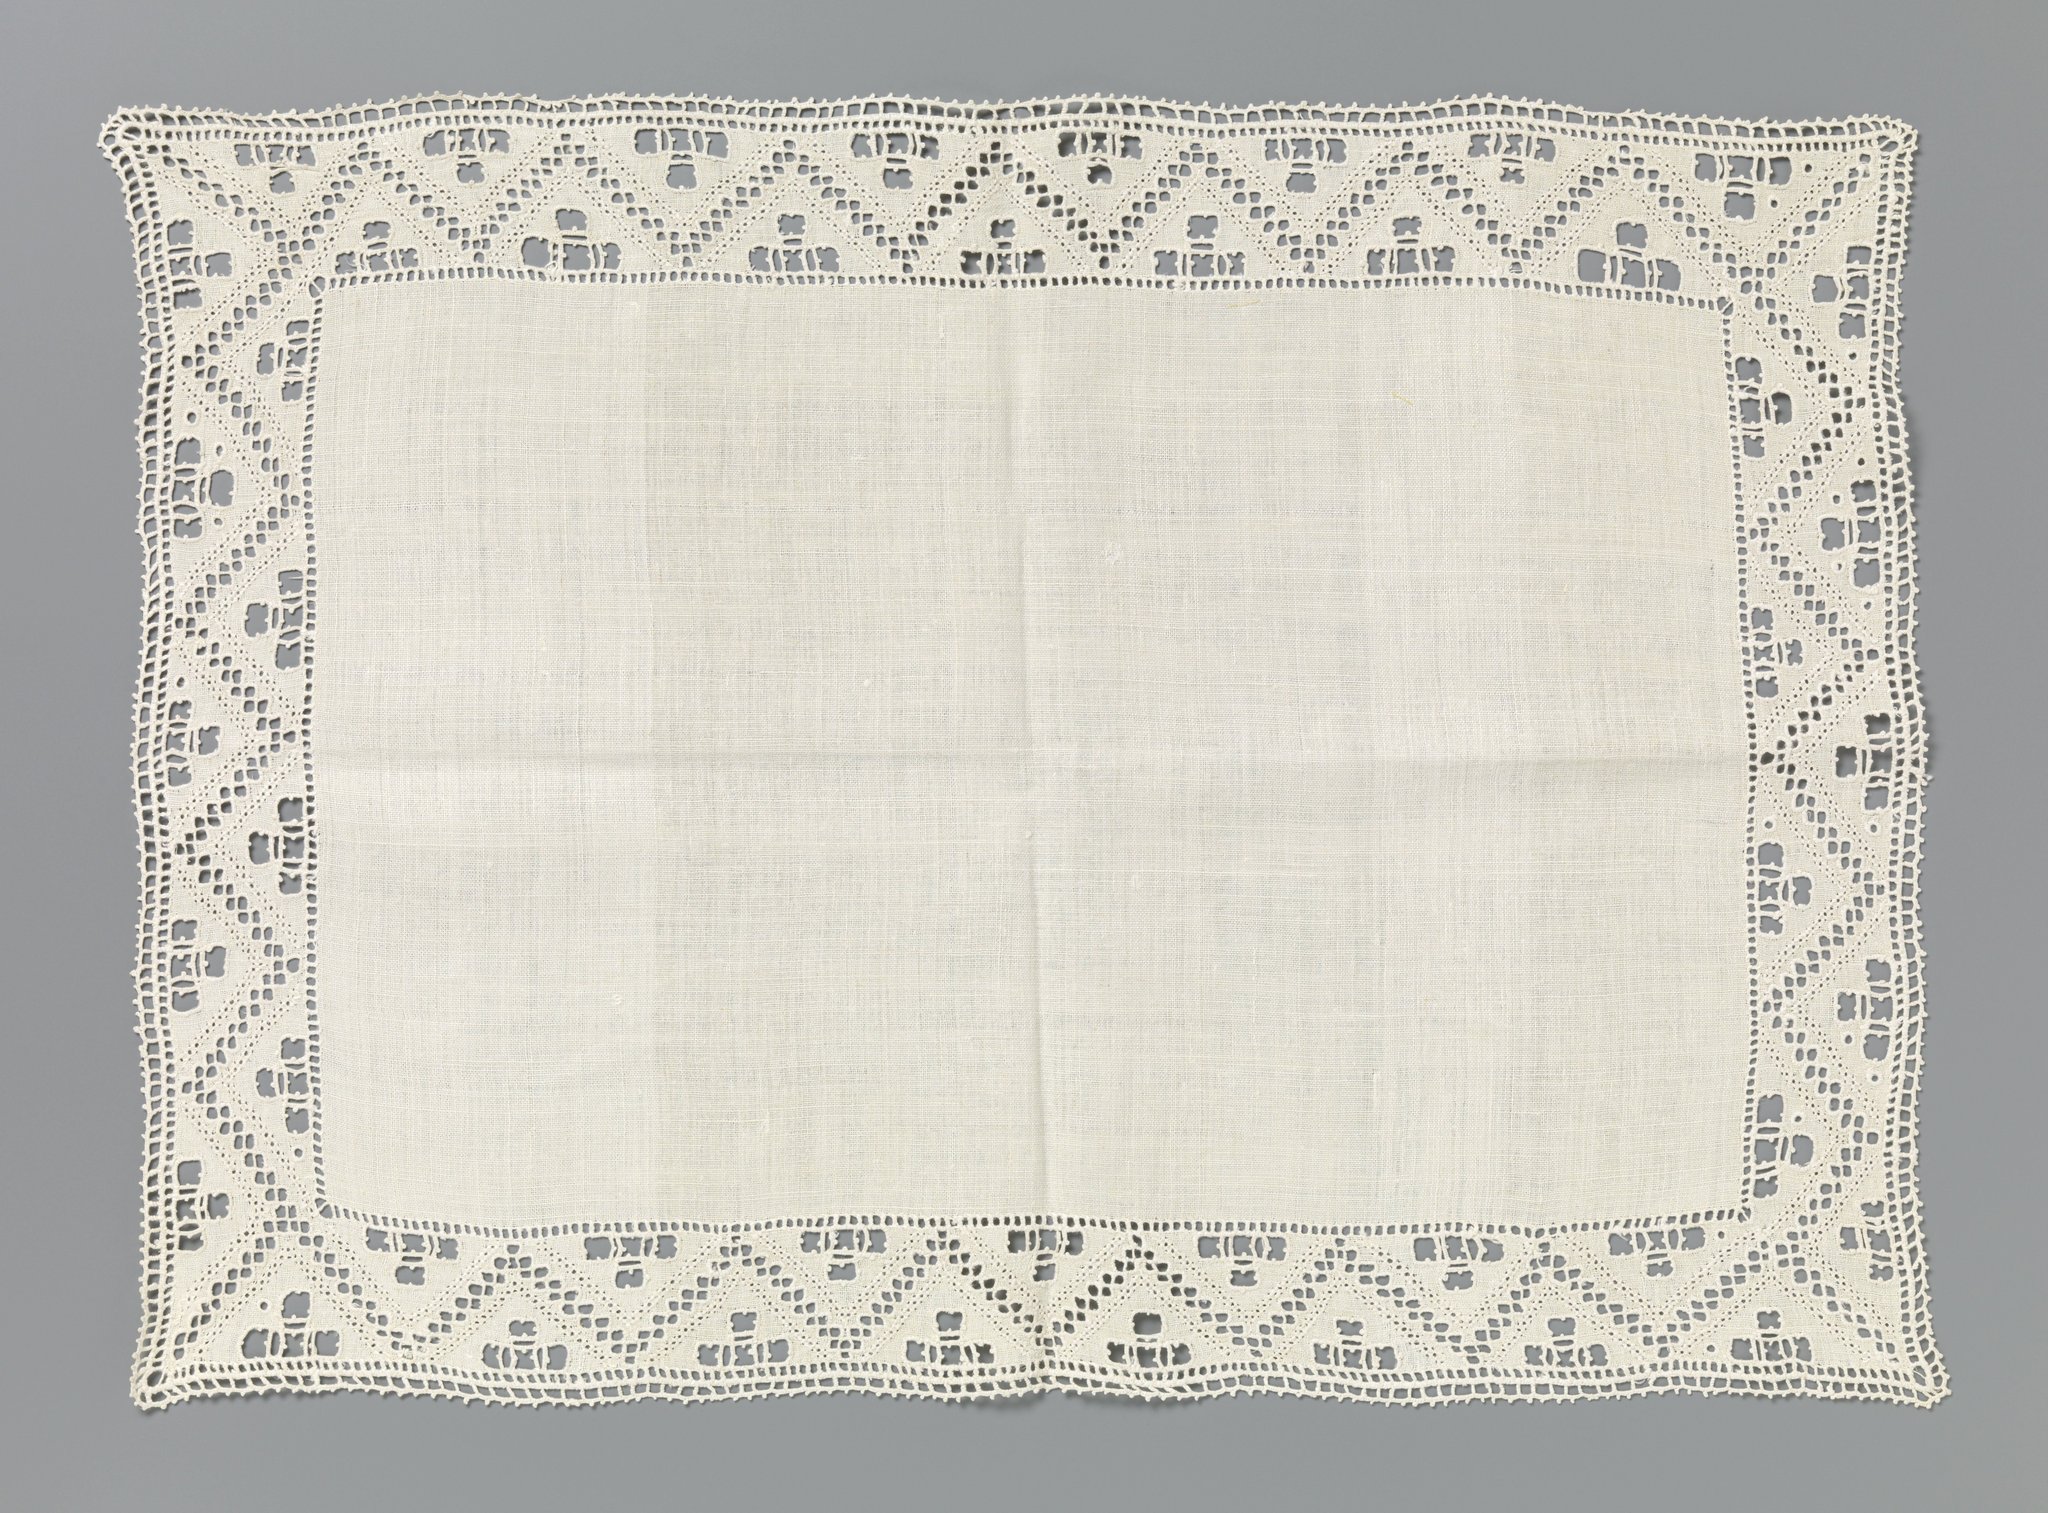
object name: kleed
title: Kleed van linnen met rondom een rand kantborduurwerk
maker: Anonymous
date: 1930-1950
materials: linen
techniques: lace embroidery, openwork embroidery, work with drawn threads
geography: europe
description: Kleed van naturelkleurig linnen waarbij de rand is voorzien van kantborduurwerk: open naaiwerk. Het zich herhalende patroon bestaat uit een zigzag-band met in de driehoekige velden erboven en eronder vier opengewerkte blokjes op elkaar gestapeld zijn, drie onder en één er in het midden bovenop. De zigzag-band bestaat uit een dubbele rij opengewerkte blokjes tussen twee smallere lijnen van elk driedubbele rij fijnere opengewerkte stippen. Rondom is het kleed afgewerkt met een gefestonneerd boogjesrandje, met aan elk boogje een picot.